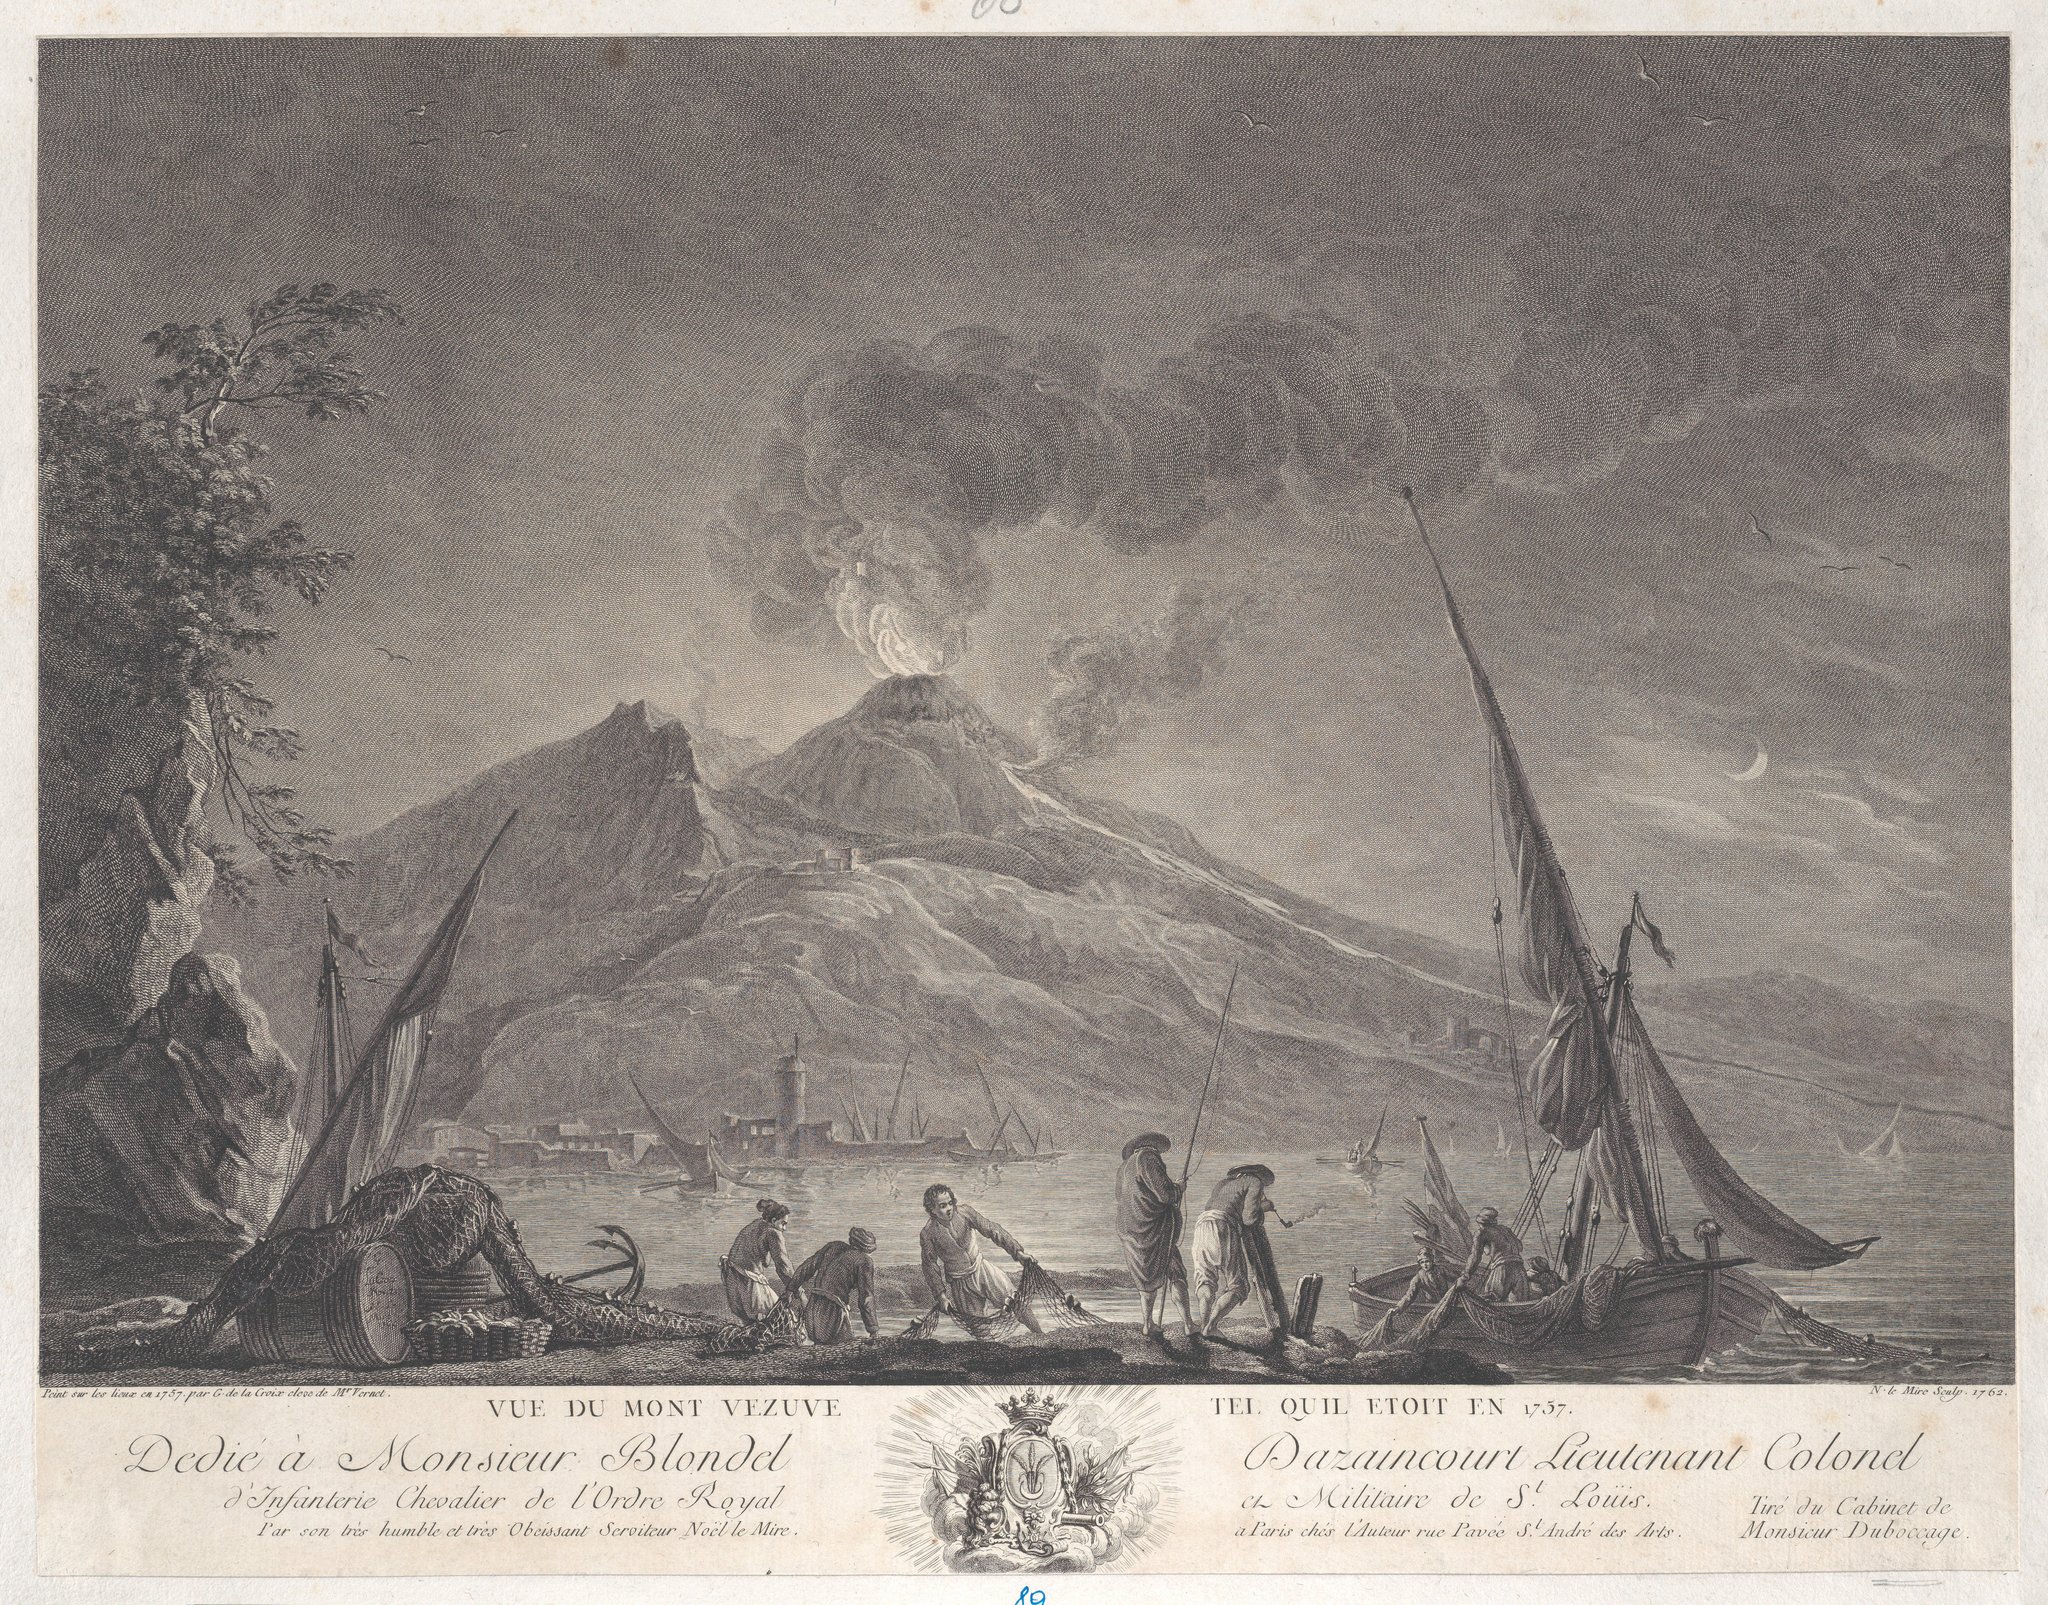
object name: print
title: View of Mount Vesuvius as it was in 1757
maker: charles françois grenier de lacroix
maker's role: artist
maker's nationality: french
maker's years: 1700-1782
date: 1762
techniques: engraving